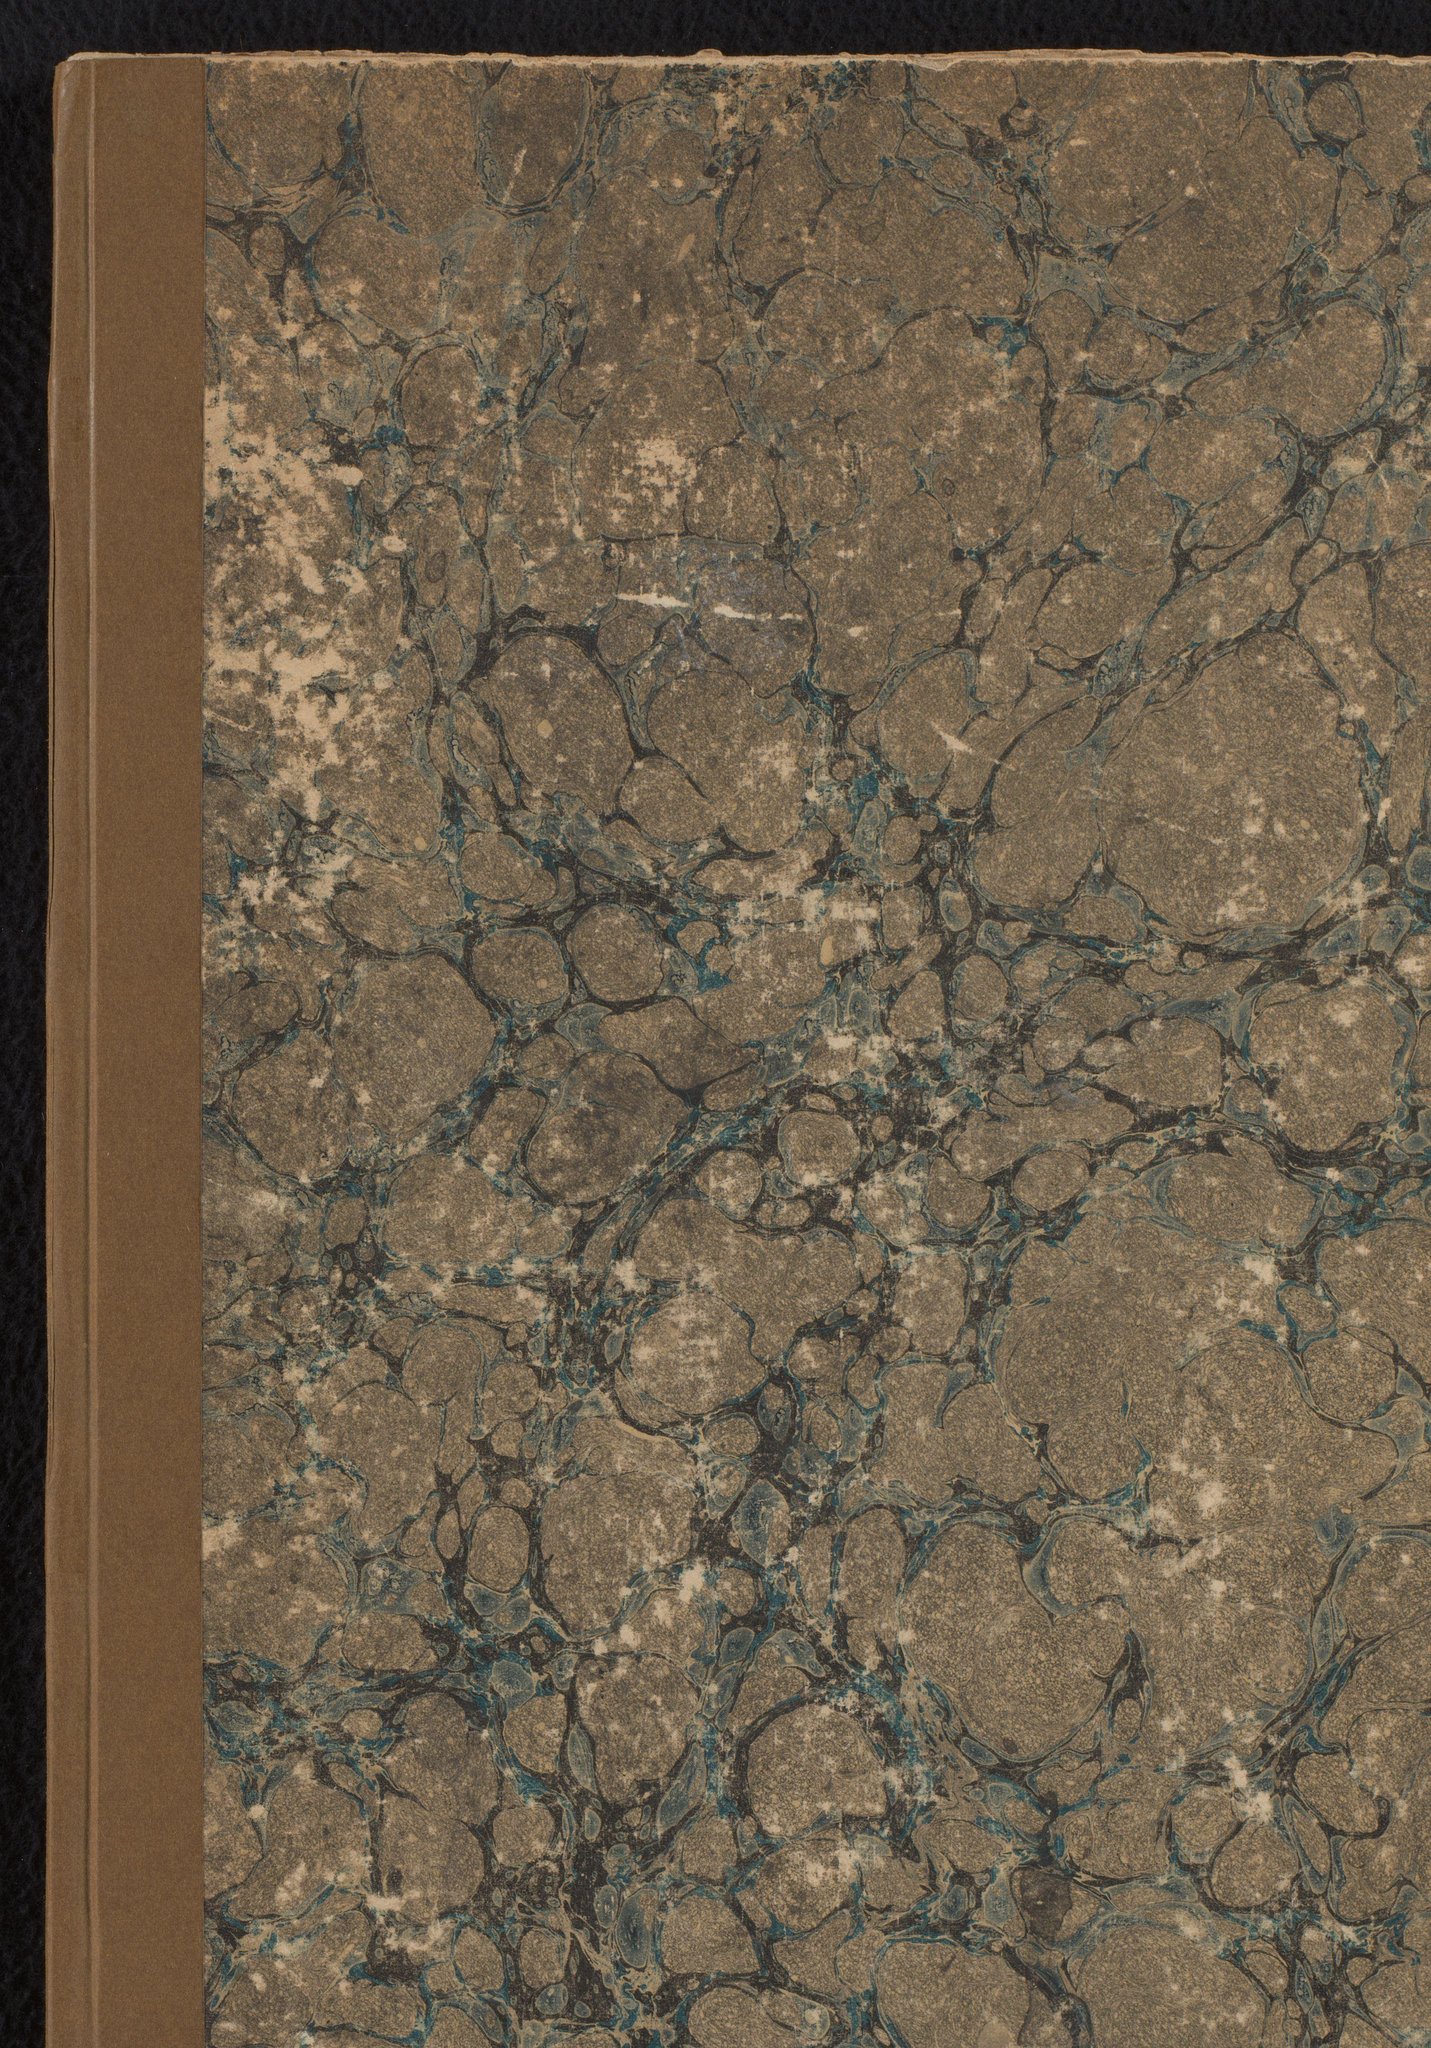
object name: prentrecueil, prentenalbum, prentalbum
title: Album met boegen en boegbeelden van zeilschepen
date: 1798-1801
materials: cardboard, paper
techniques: bookbinding, engraving, etching, marbling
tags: sailing-ship, sailing-boat, parts of ship's exterior: bow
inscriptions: collector's mark: Lugt 2760, collector's mark: Lugt 2228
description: Album met 24 prenten op 24 bladen. De prenten vertonen voorstevens van diverse soorten zeilschepen uit de serie 'Ornements de la proue de différents vaisseaux'.